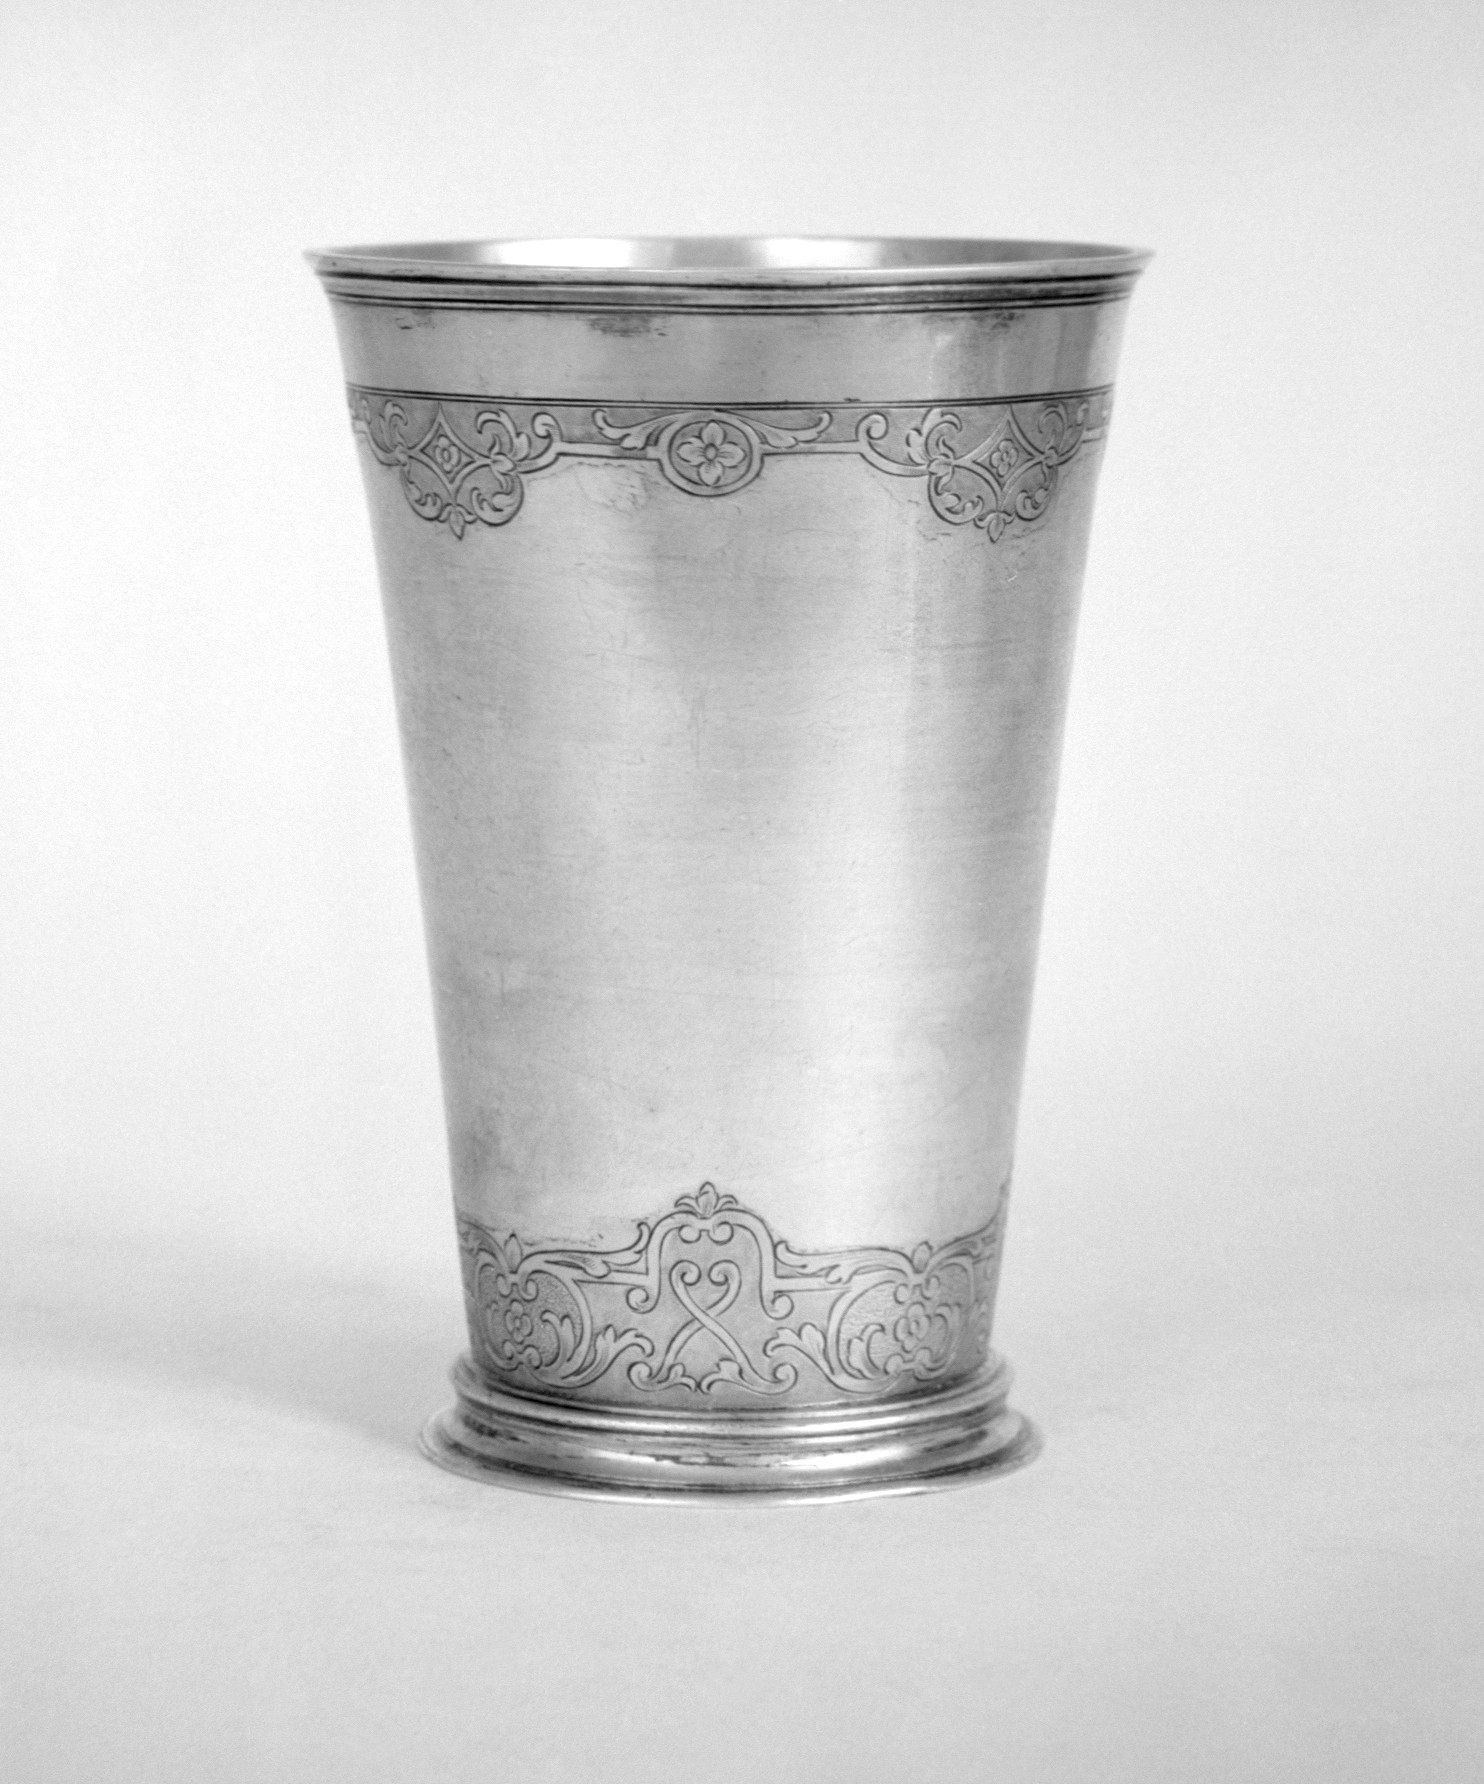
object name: beaker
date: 1750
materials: gilt, silver